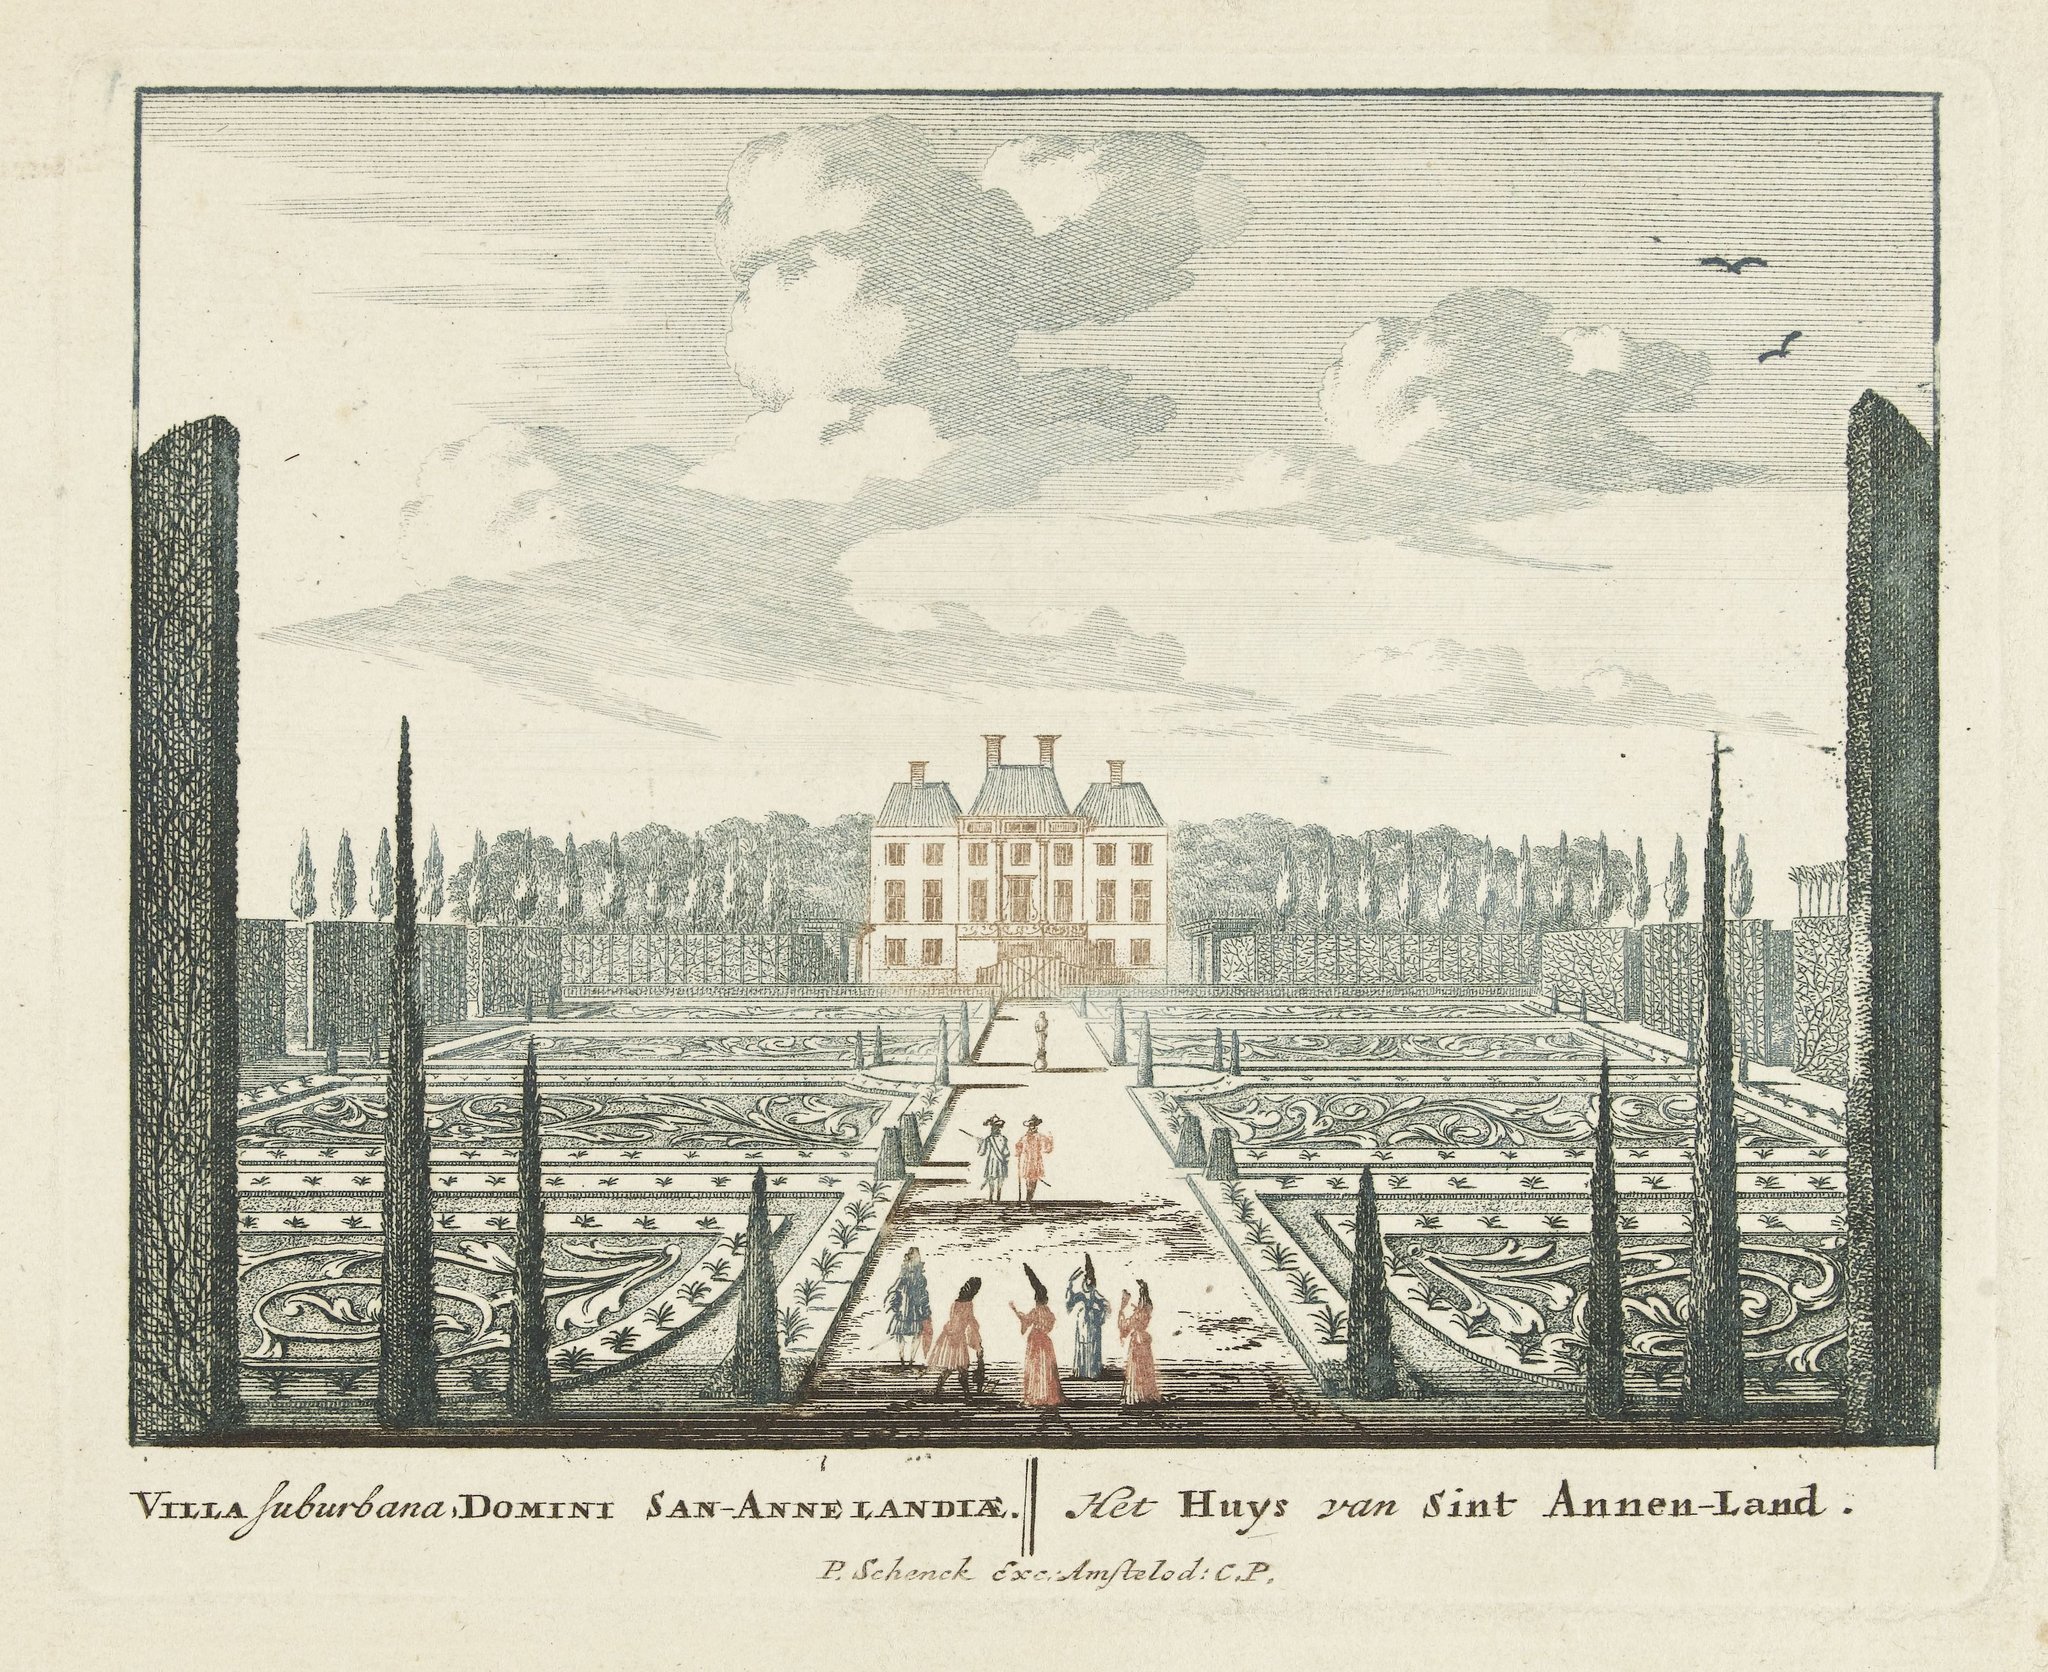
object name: print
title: Uitgeleesene Gesichte van het Wijdvermaarde Loo als andere vorstelijke Huisen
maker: pieter schenk (i)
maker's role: print maker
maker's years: 1660-1711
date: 1695-1705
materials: paper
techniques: etching, lithography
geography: amsterdam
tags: french or architectonic garden; formal garden, 'jeu de boules', greenhouse, orangery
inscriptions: collector's mark: Lugt 2228, collector's mark: Lugt 1516a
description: Prent uit een serie van 71 prenten met Rijnlandschappen, gezichten op vorstelijke paleizen en stadsgezichten uit Den Haag en Amsterdam. Dit is prent 44 uit de serie. Het landhuis Clingendael wordt in het onderschrift Huis van St. Annen-land genoemd omdat het destijds in bezit was van de Heer van St. Annaland.